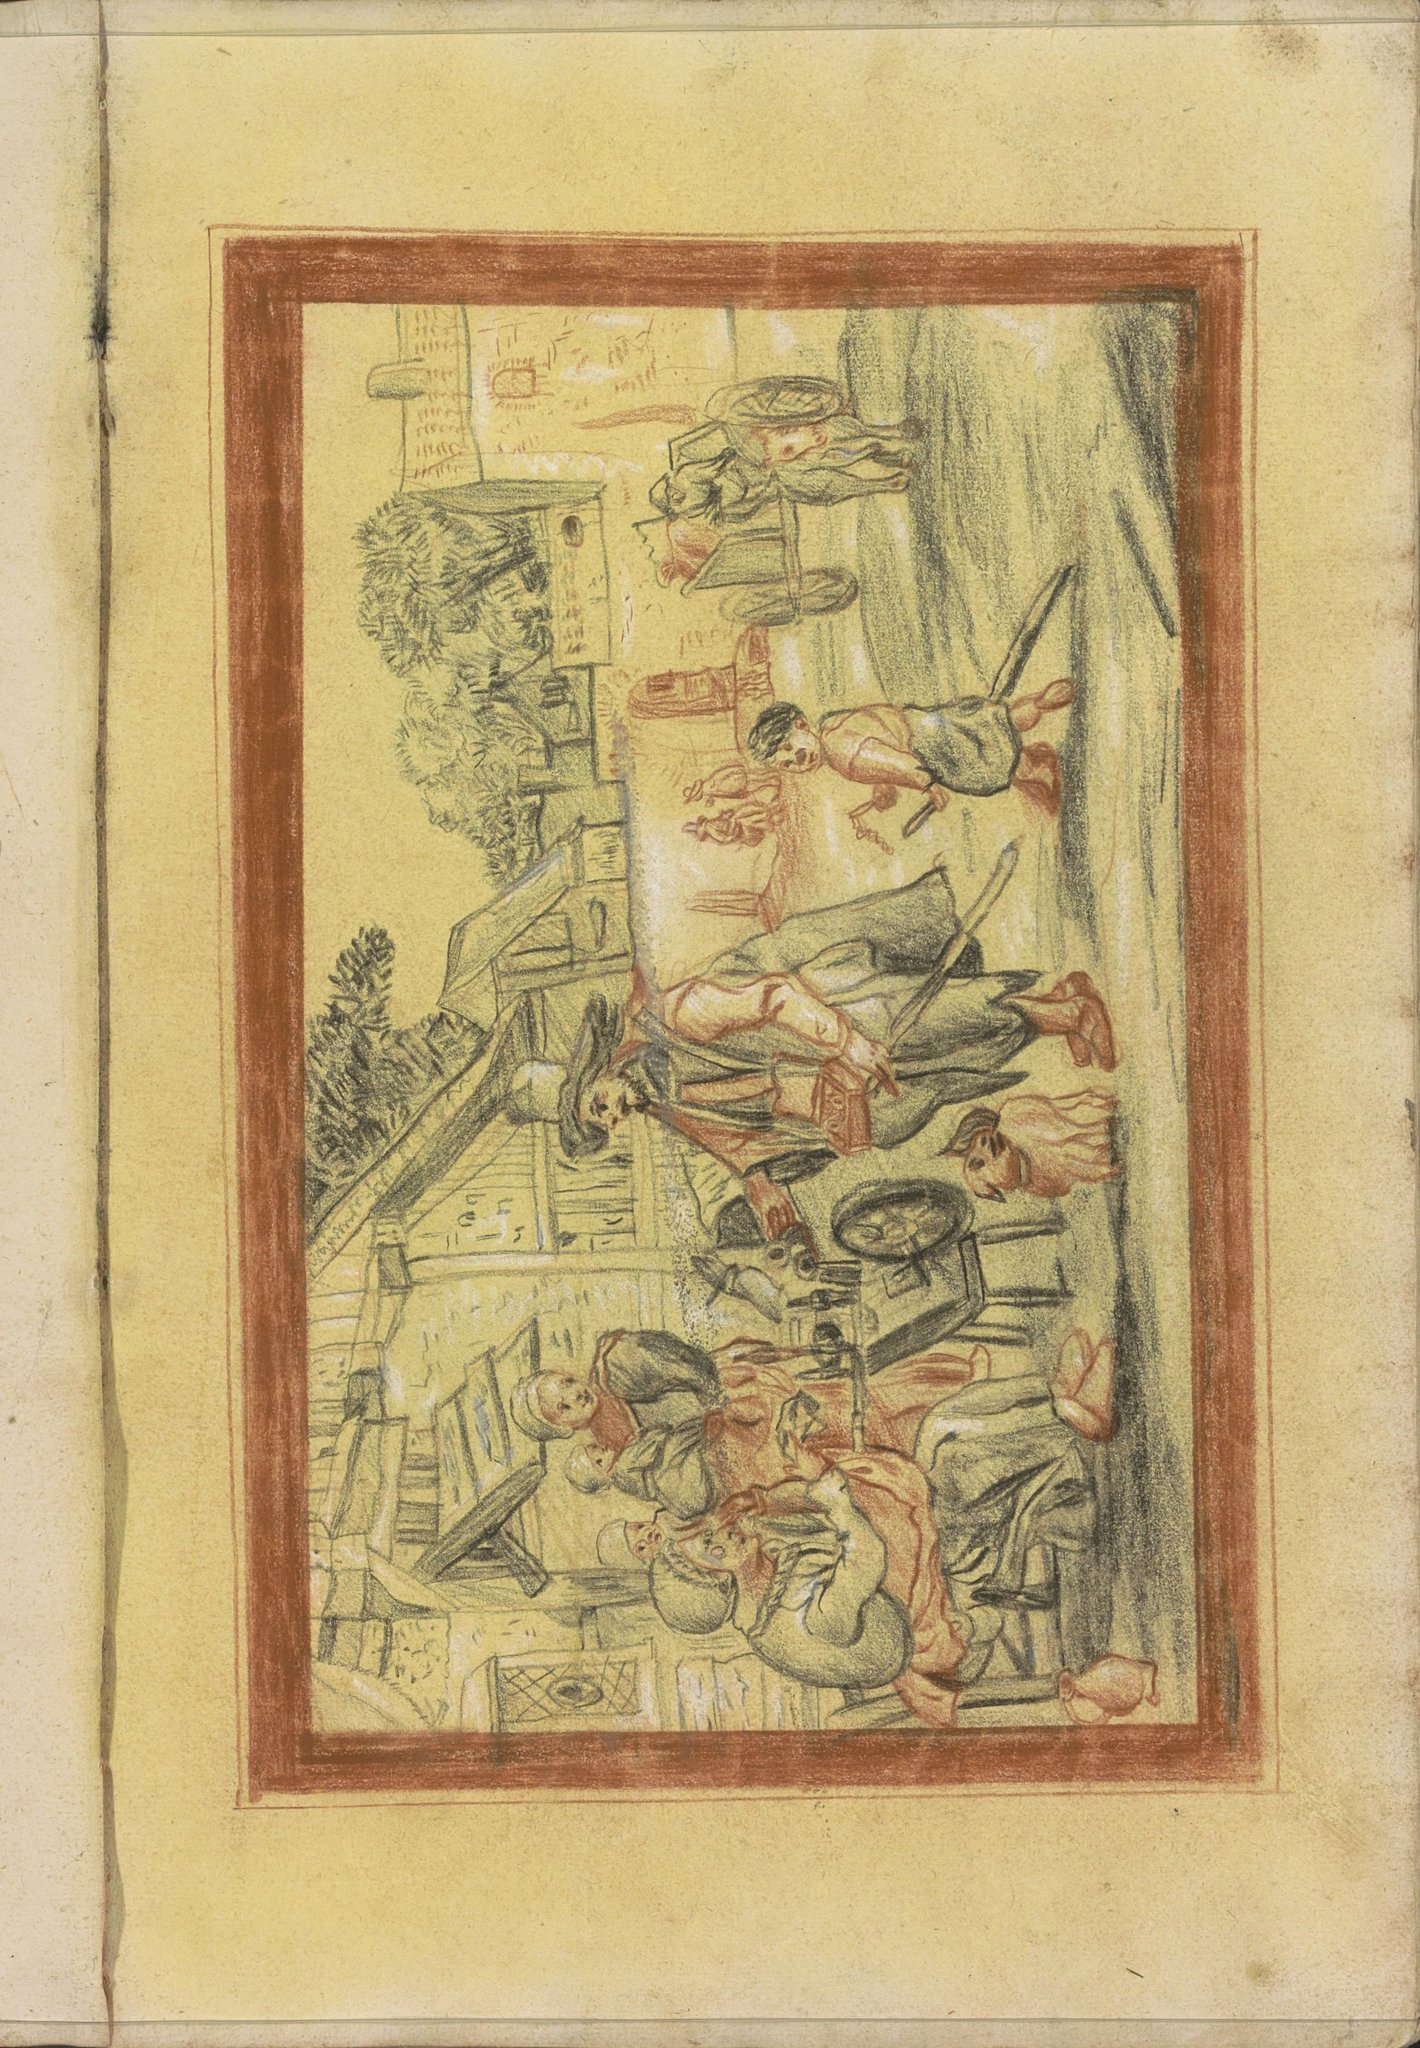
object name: sketchbook leaf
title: Dorpsstraat met een brillenverkoper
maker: hendrick van beaumont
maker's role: draughtsman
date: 1696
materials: chalk, paper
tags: merchant, salesman, village street (+ city(-scape) with figures, staffage)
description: Blad 38 recto uit een schetsboek met 91 bladen.